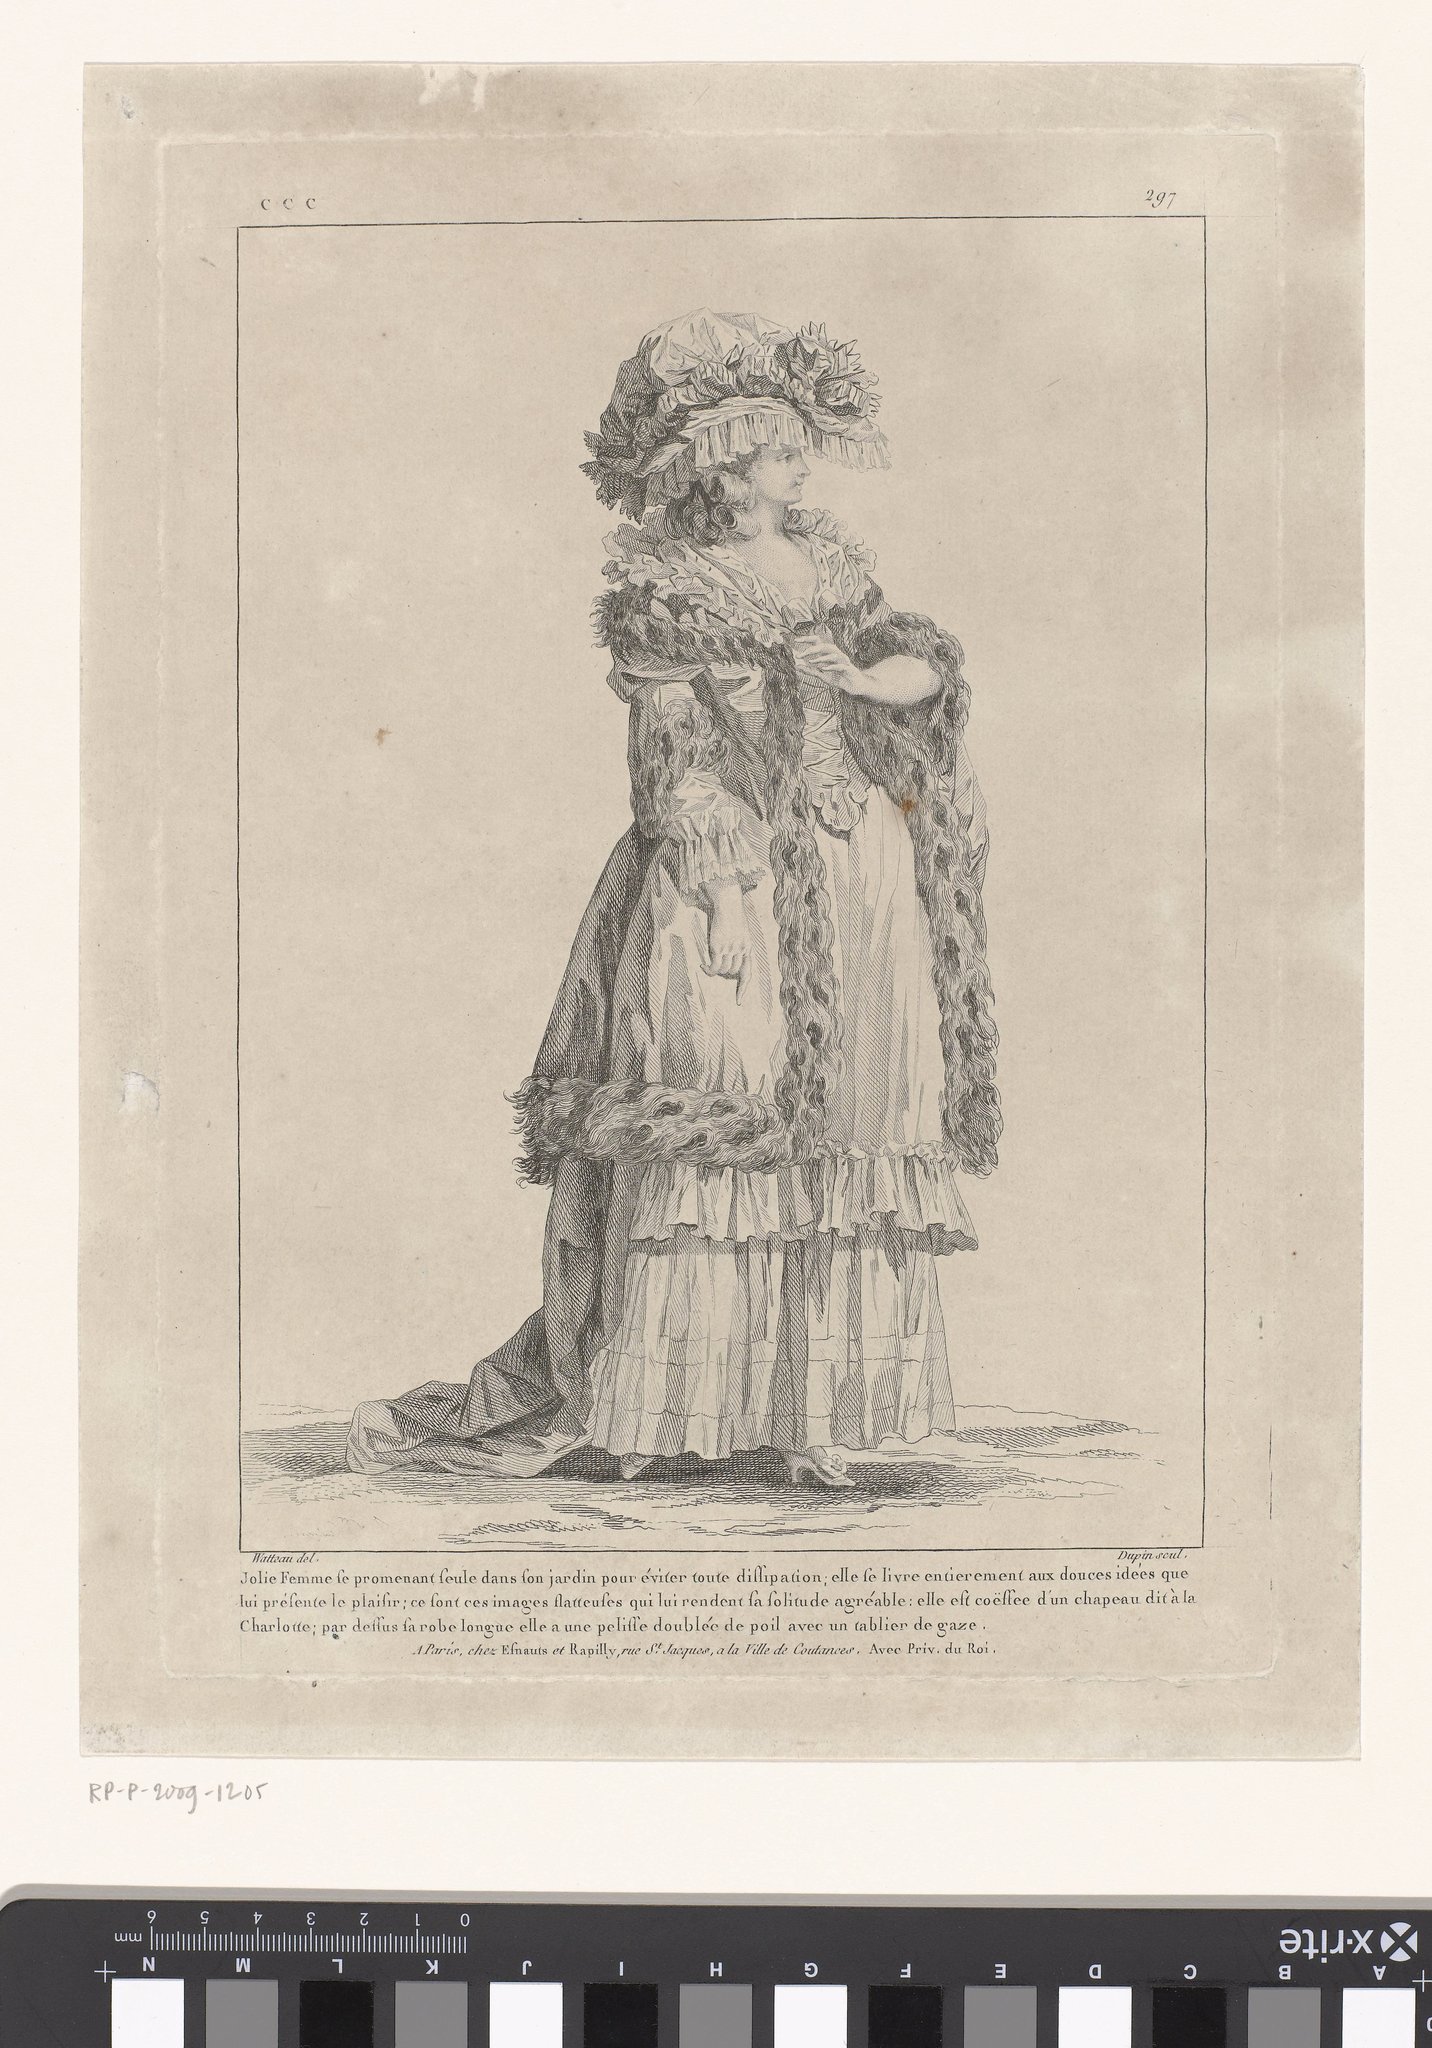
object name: fashion print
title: Gallerie des Modes et Costumes Français, 1785, ccc 297 : Jolie Femme se promenant seul (...)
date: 1785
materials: paper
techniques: hand coloring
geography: paris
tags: head-gear (chapeau a la charlotte) (+ women's clothes), cape (pelisse) (+ women's clothes), fashion plates, head-gear: hat (+ women's clothes), shoes, sandals (+ women's clothes), skirt (+ women's clothes), dress, gown (+ women's clothes), apron (+ women's clothes), piece of clothing covering the breast or décolleté (fichu) (+ women's clothes)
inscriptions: address: ‘A Paris, chez Esnauts et Rapilly, rue St. Jacques, a la Ville de Coutances. Avec Priv. du Roi.’, caption: ‘Jolie Femme se promenant seule dans son jardin pour éviter toute dissipation; elle se livre entierement aux douces idées que lui présente le plaisir ; ce sont ces images flatteuses qui lui rendent sa solitude agréable : elle est coëffee d'un chapeau dit à la Charlotte; par dessins sa robe longue elle a une pelisse doublée de poil avec un tablier de gaze.’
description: Jonge vrouw, wandelend in een tuin, gekleed in een met bont gevoerde pelisse op een lange japon. Sierschort van tule. Op het hoofd een hoed 'à la Charlotte'. Om de hals een fichu. Schoenen met hakken en strikken. Prent uit de serie ccc. 47e Cahier des Costumes Français, 42e Suite d'Habillemens à la mode, Gallerie des Modes et Costumes Français.